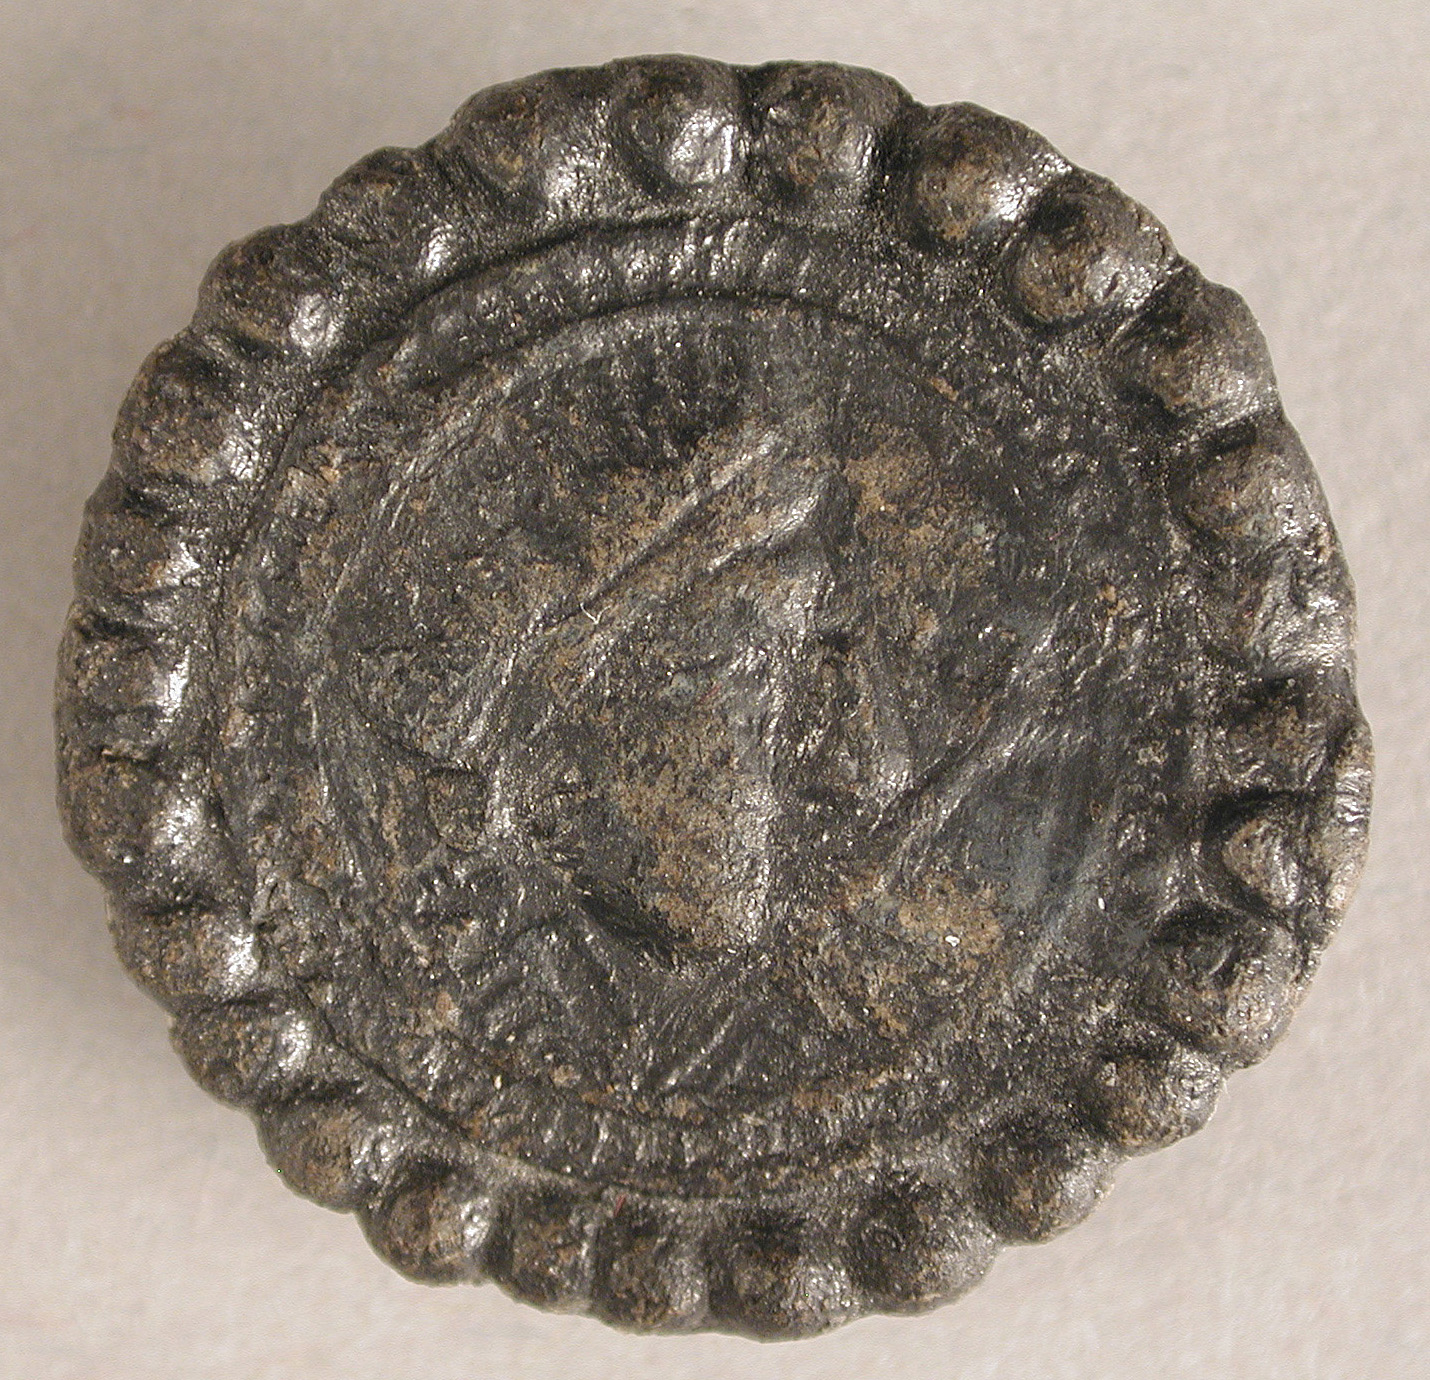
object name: pilgrim's badge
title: Badge of Edward II or John the Baptist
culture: british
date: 1301-1500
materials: alloy, lead, tin